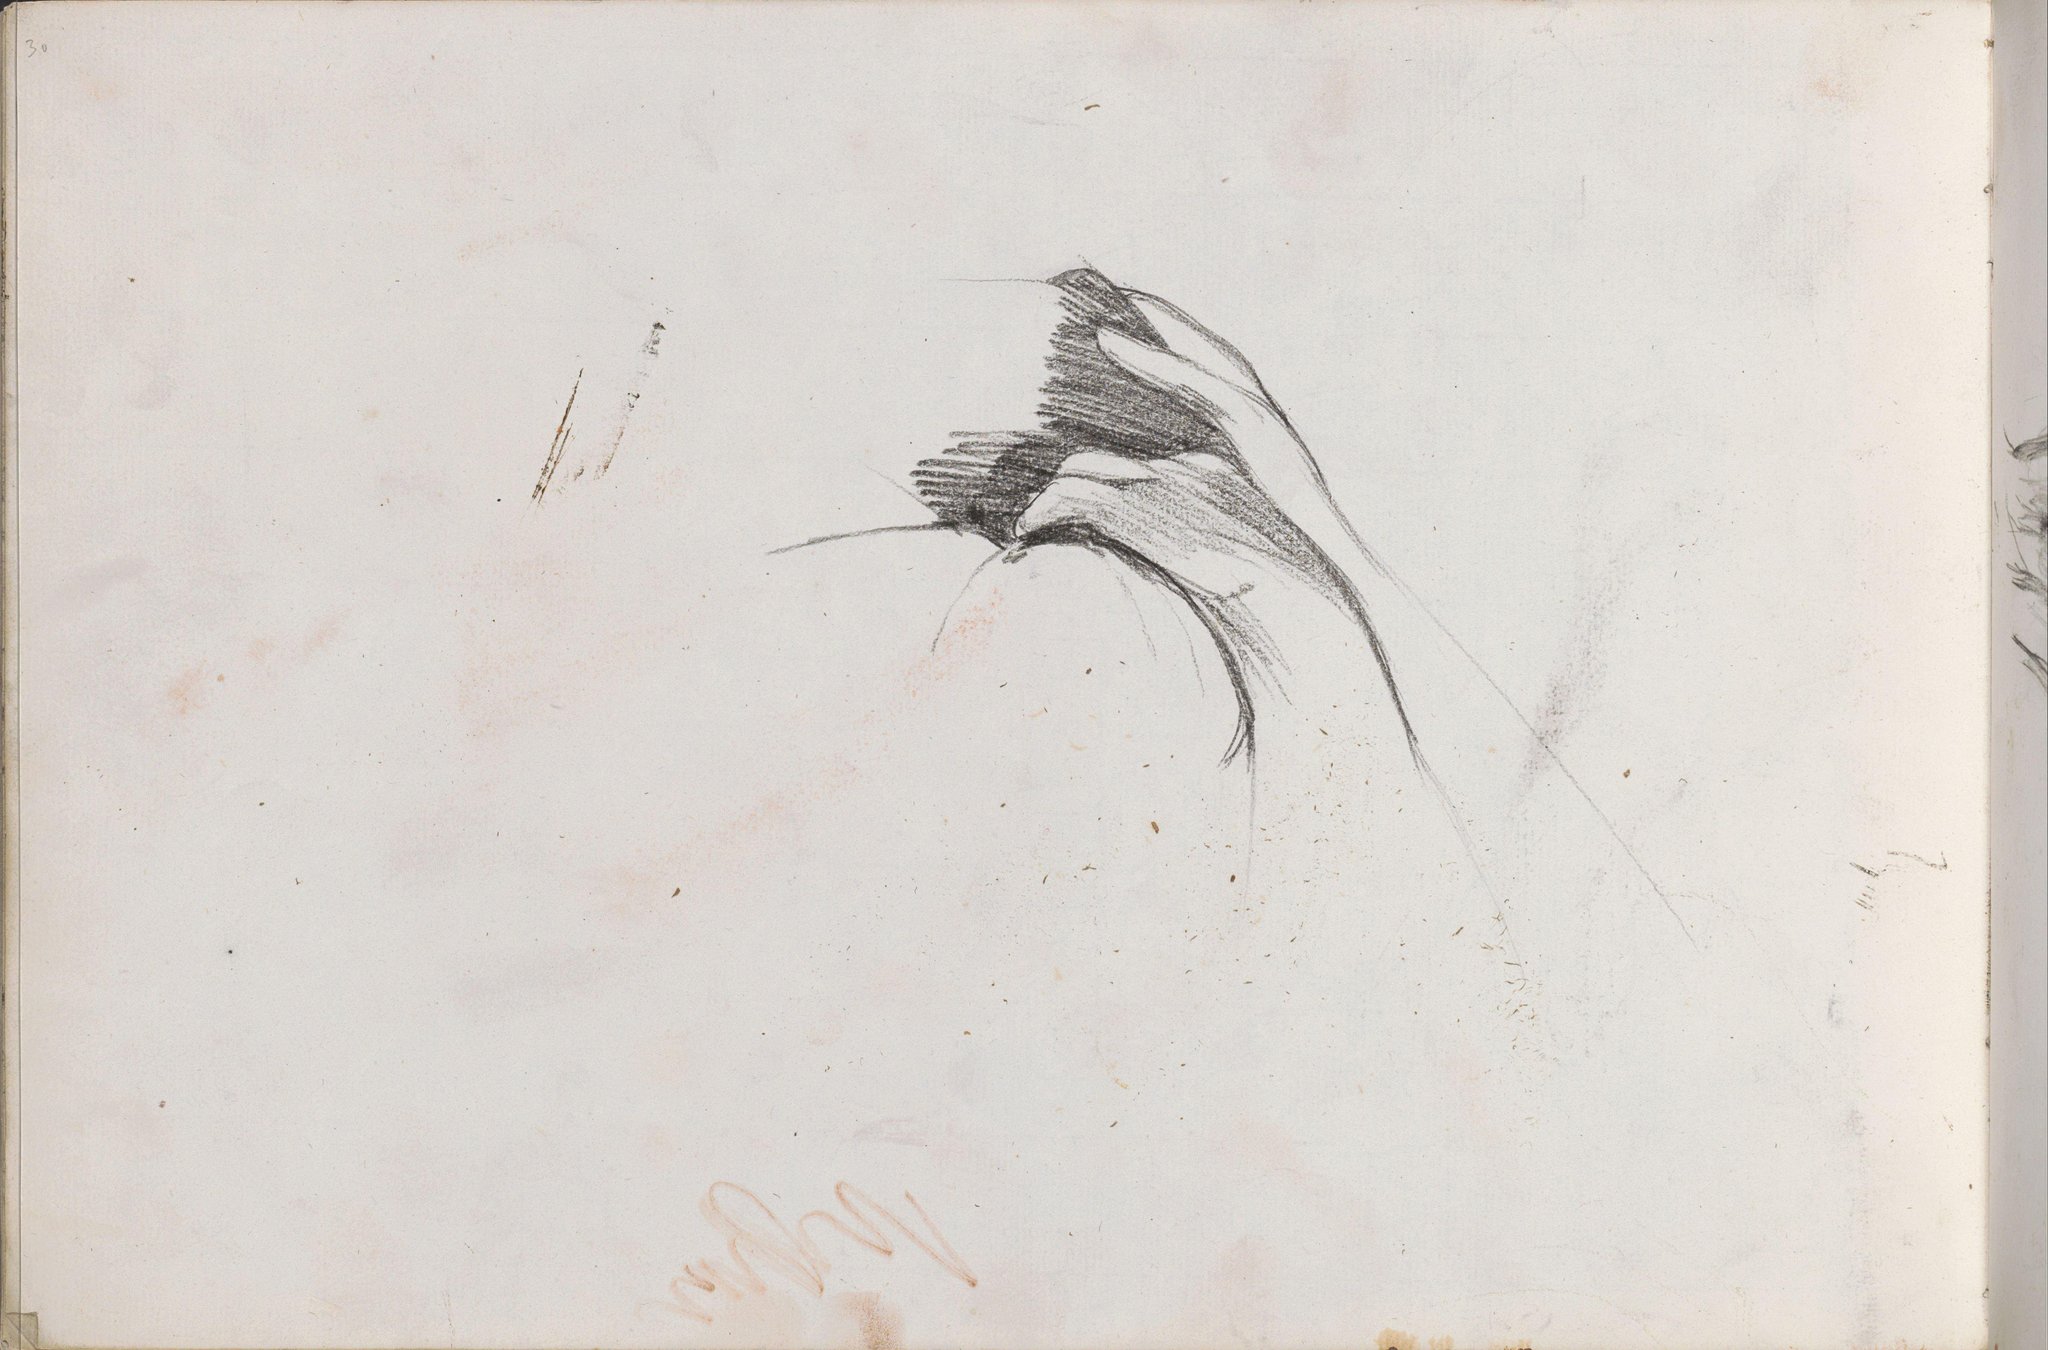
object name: sketchbook leaf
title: Hand die een voorwerp vastpakt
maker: willem witsen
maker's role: draughtsman, painter, print maker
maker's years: 1860-1923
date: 1887-1892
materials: chalk, paper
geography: amsterdam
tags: hand, grasping something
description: Pagina 30 uit een schetsboek met 17 bladen.